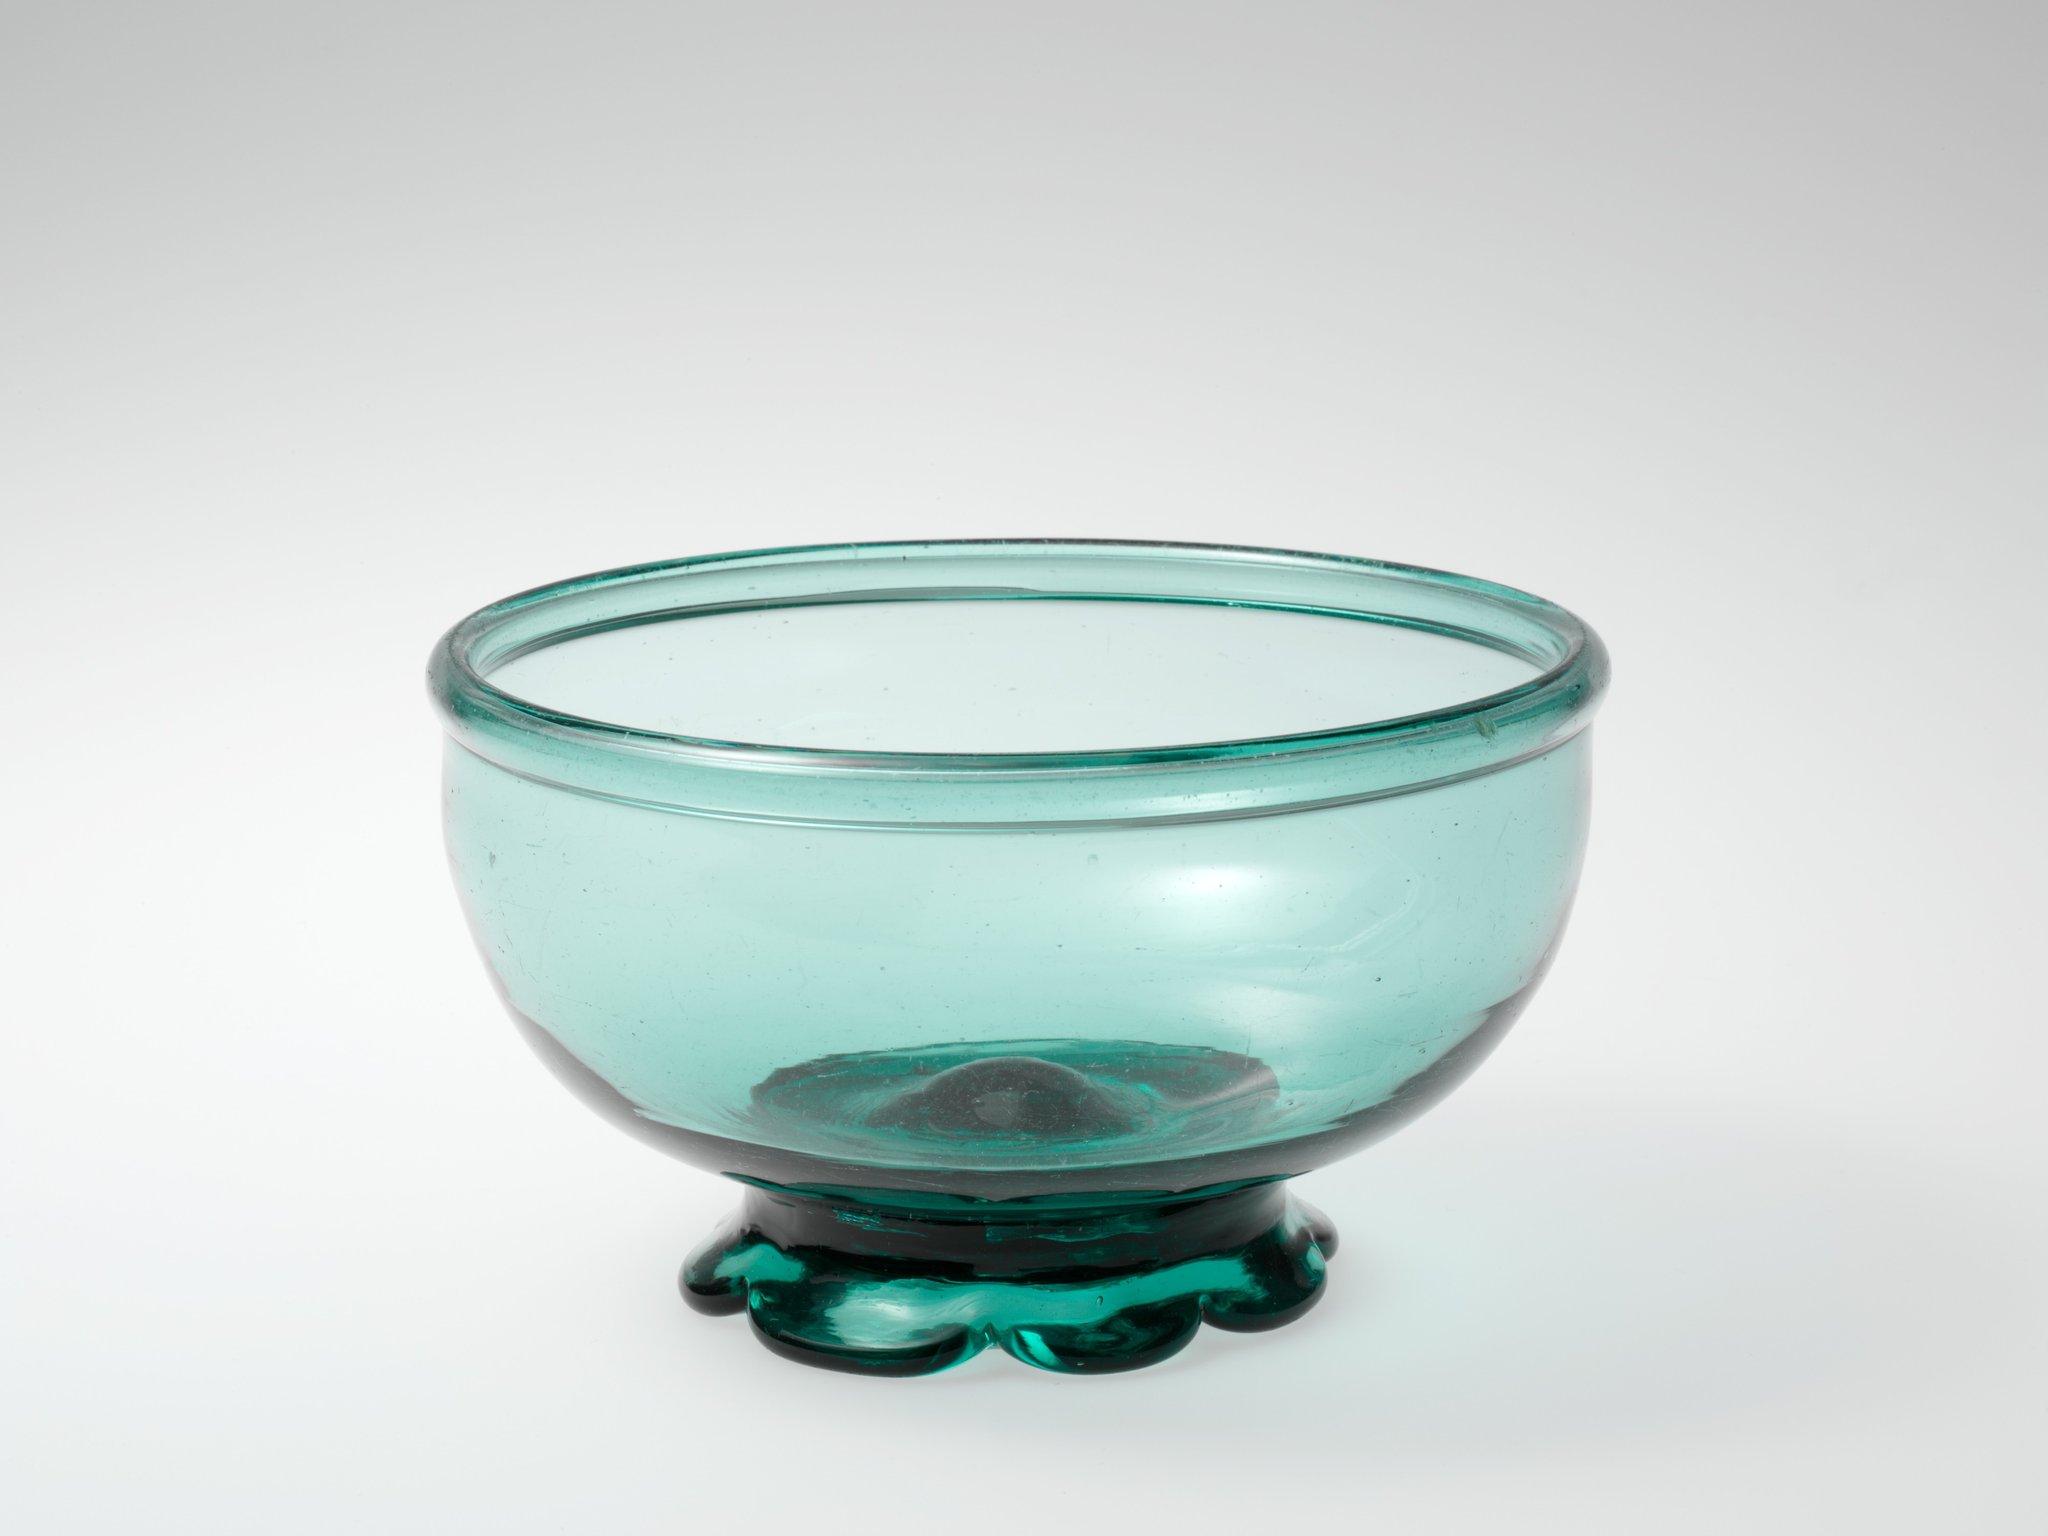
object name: bowl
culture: american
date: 1820-1840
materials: glass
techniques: glassblowing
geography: united states